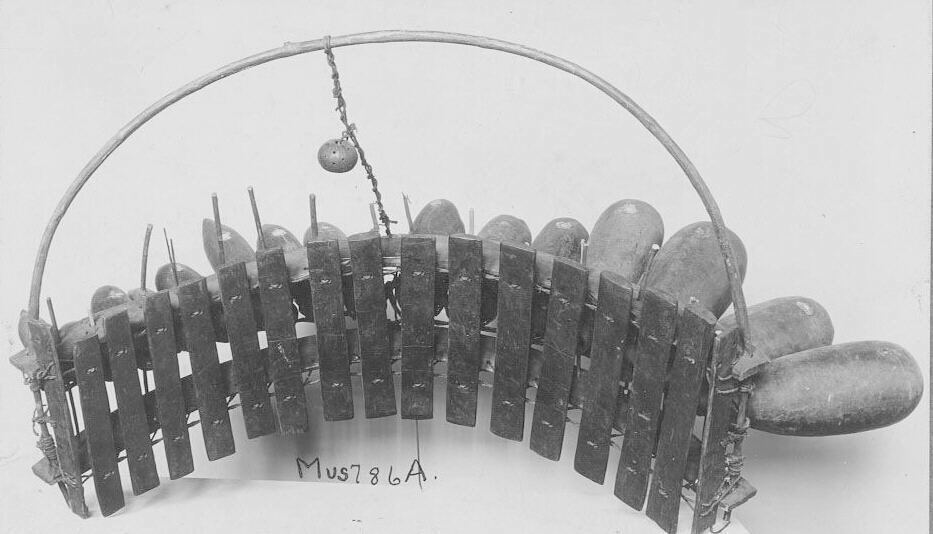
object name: xylophone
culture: african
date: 1801-1900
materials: leather, wood